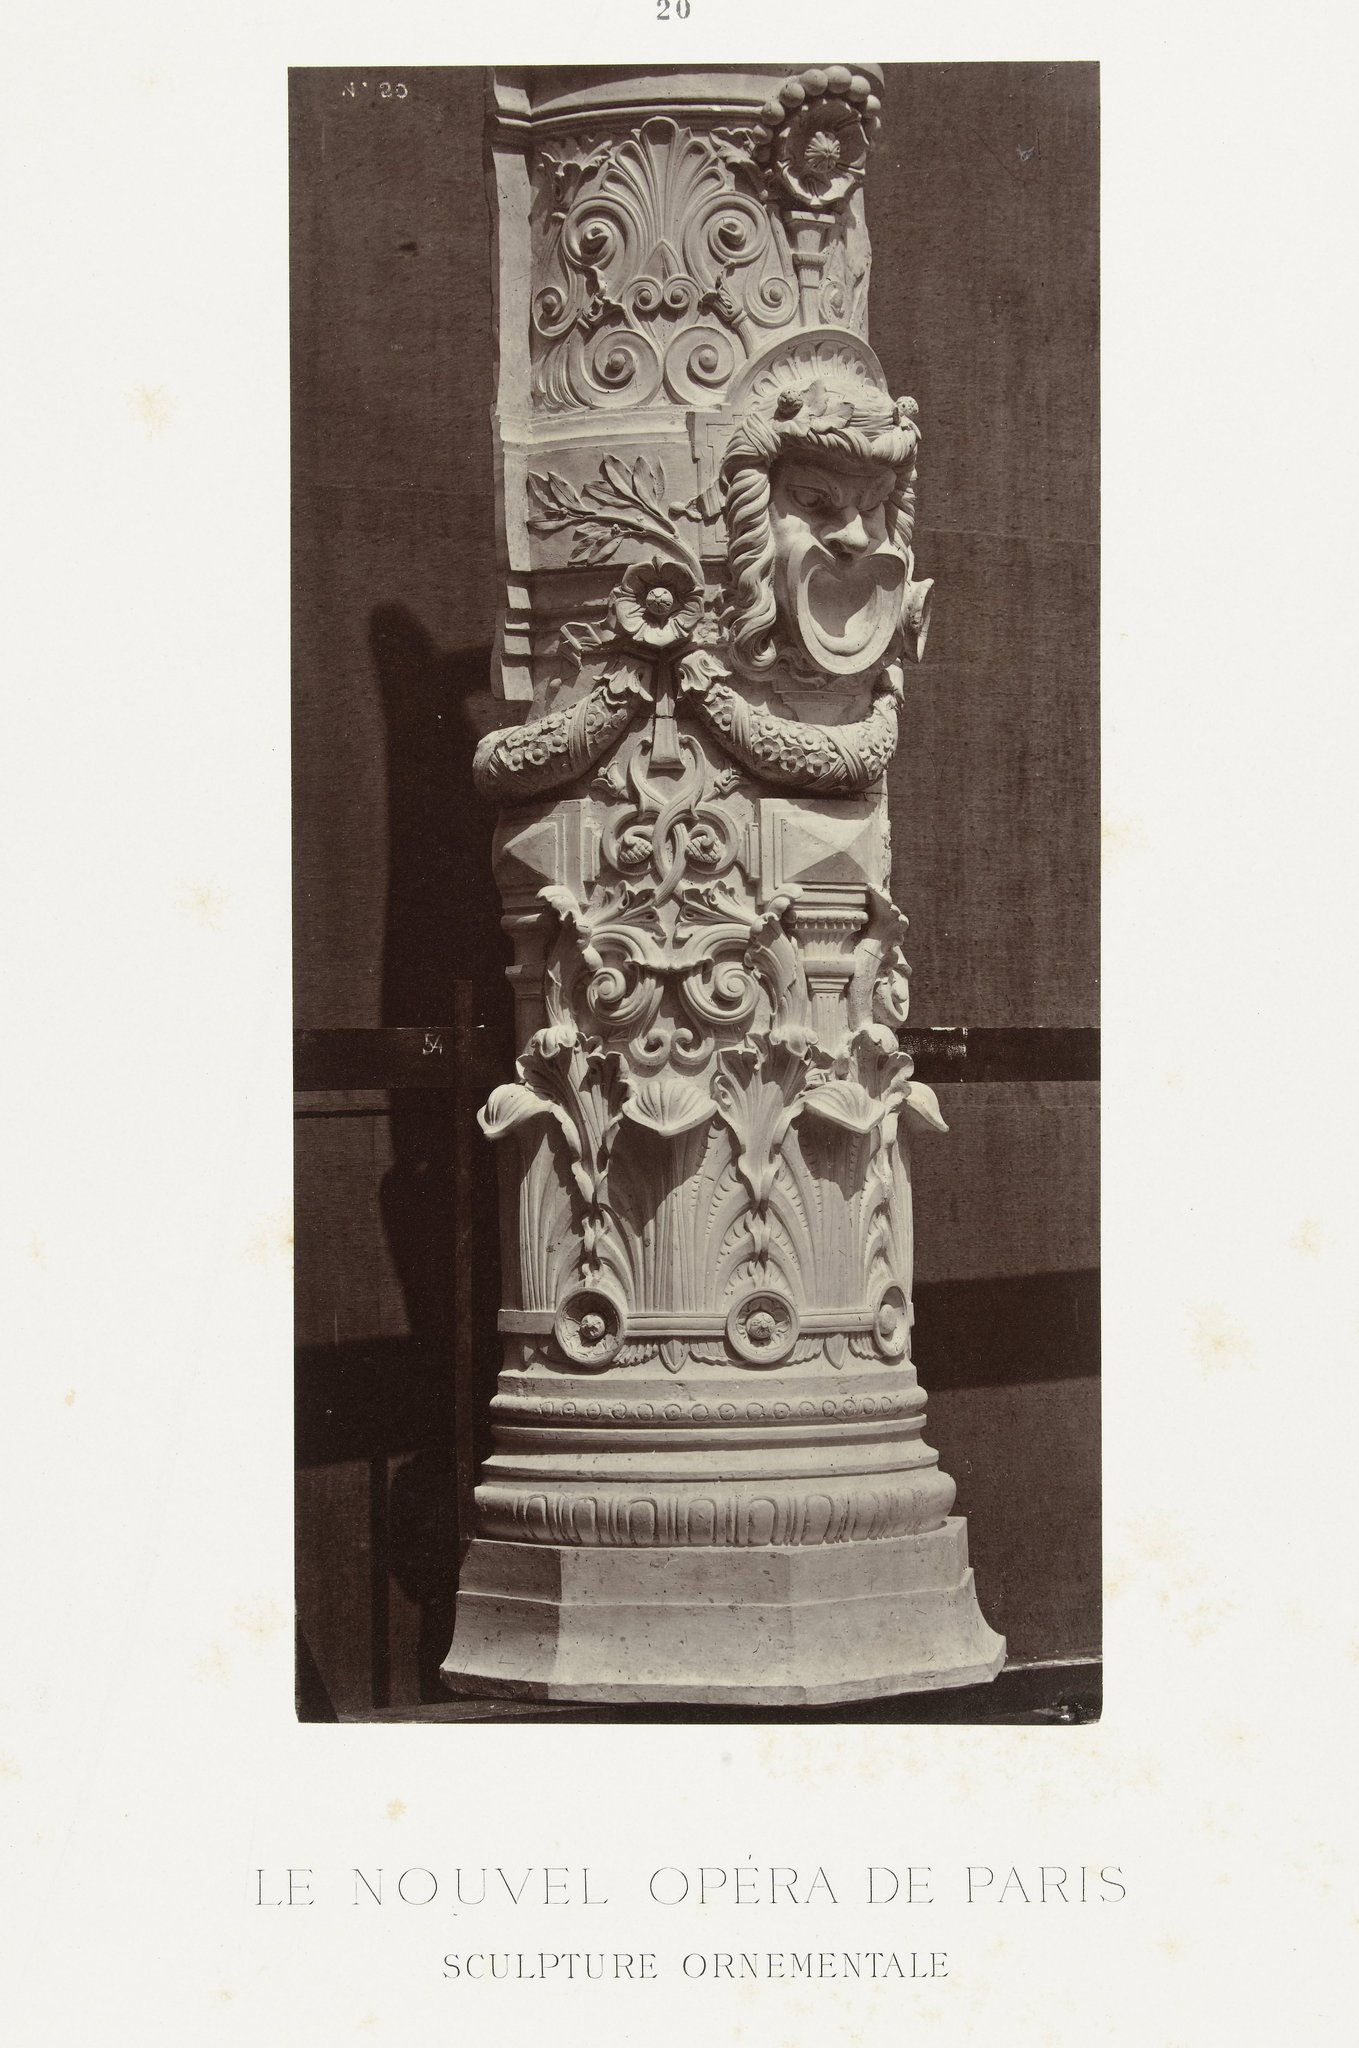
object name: photograph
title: 20. Le nouvel Opéra de Paris. Sculpture Ornamentale.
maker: louis-emile durandelle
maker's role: fotograaf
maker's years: 1839-1917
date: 1878-1881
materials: photographic support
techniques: albumen print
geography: paris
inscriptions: number: ‘9’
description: bij boek in Bibliotheek RMA, Zie Frizot, pp. 217-223, vgl G. Vicaire, Manuel de l'amateur de livres du XIXe siècle, vol. 3, column 870.